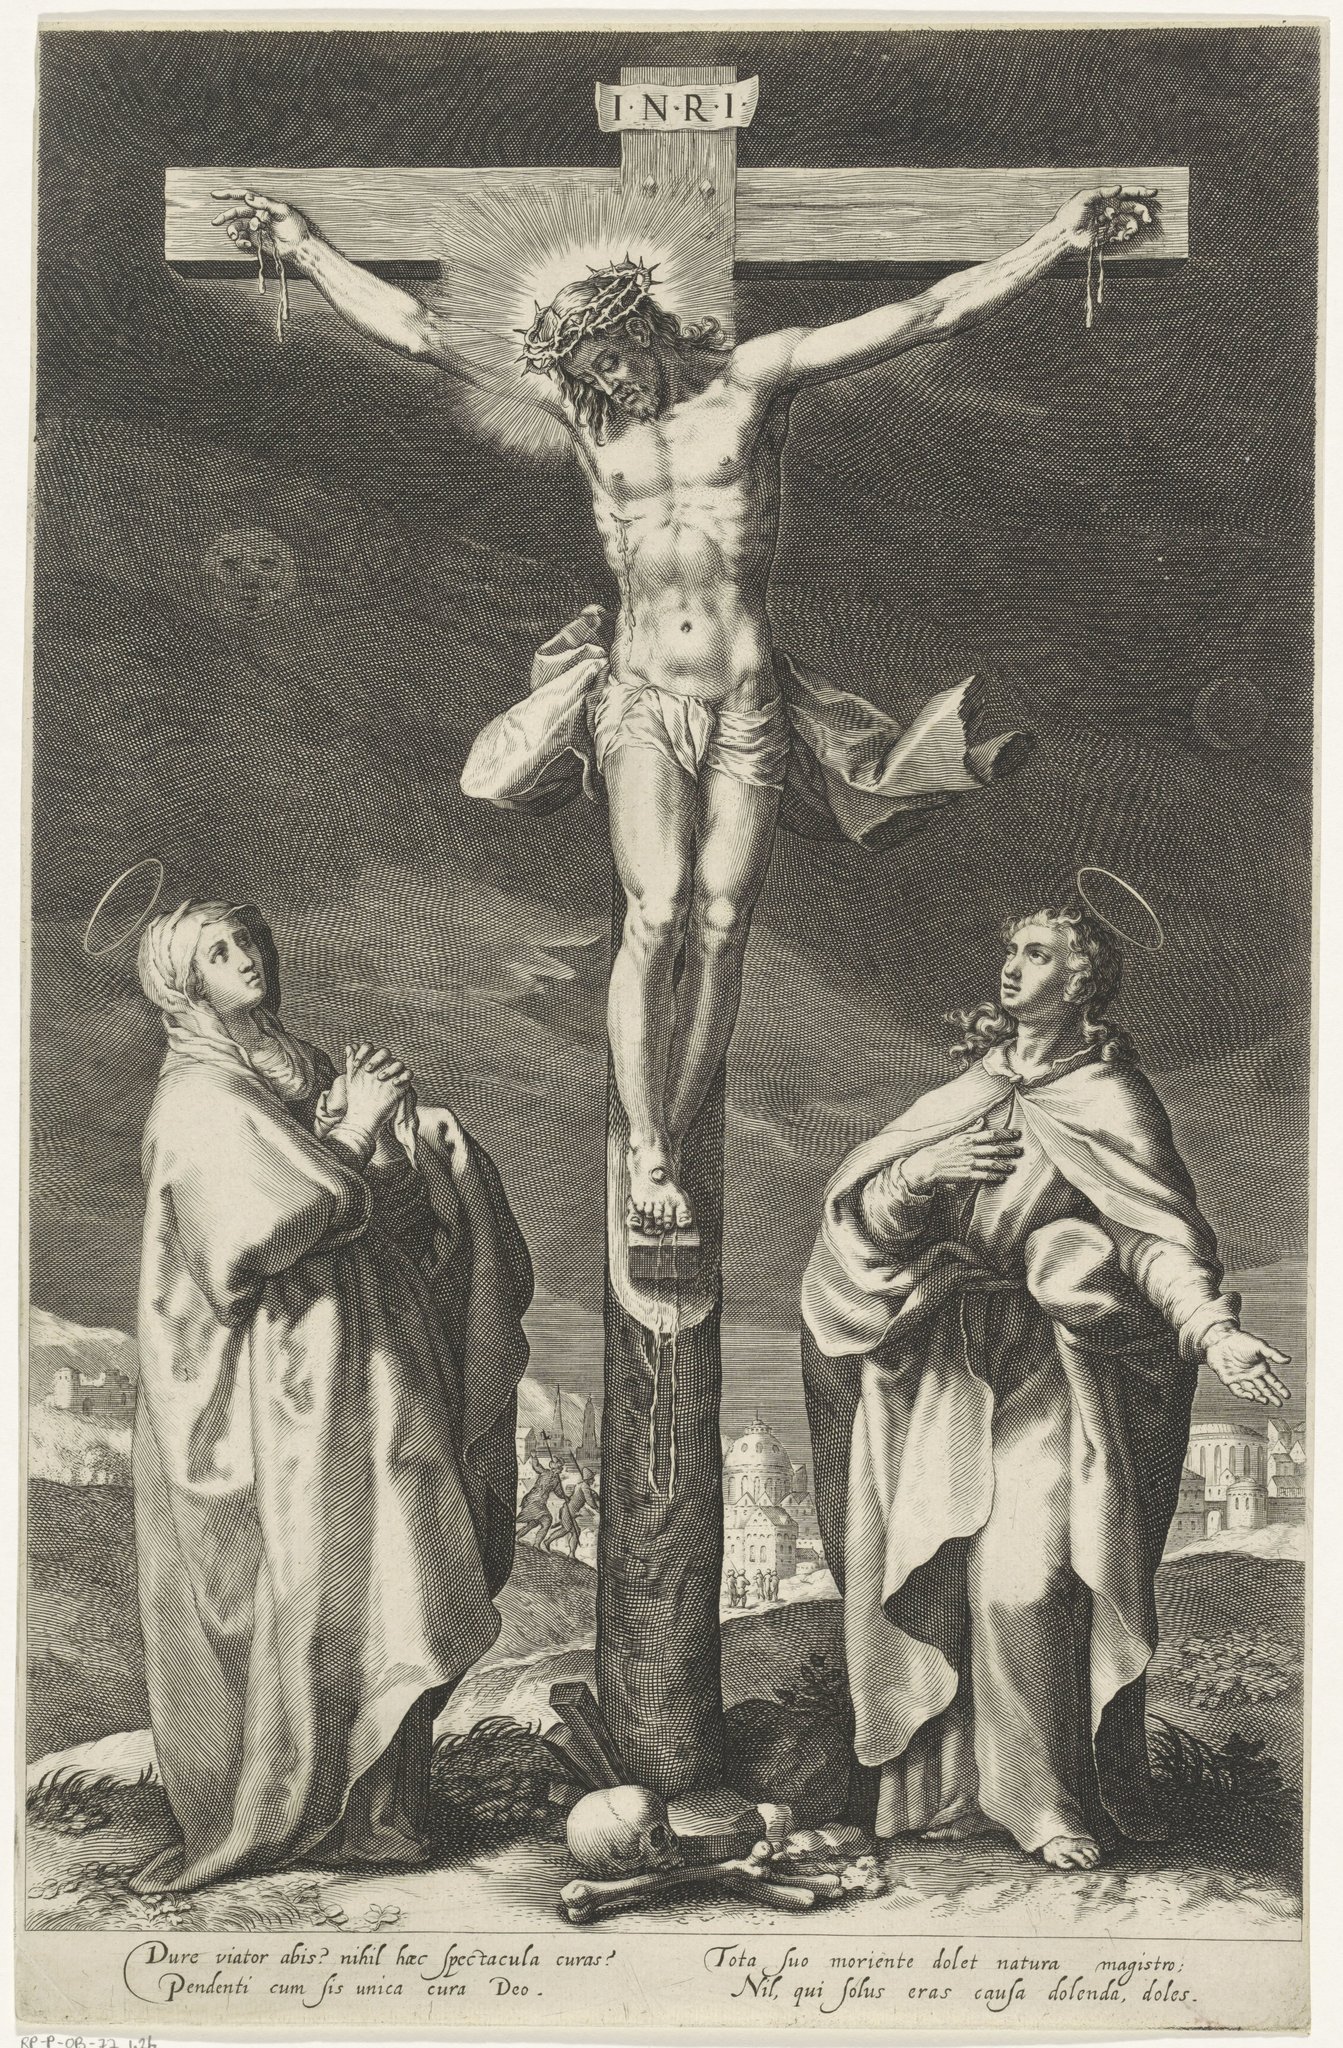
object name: print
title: Christus aan het kruis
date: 1580-1620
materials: paper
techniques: engraving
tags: crucified christ with mary and john on either side of the cross; holy rood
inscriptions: collector's mark: Lugt 240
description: Christus aan het kruis. Links staat Maria, rechts de apostel Johannes.